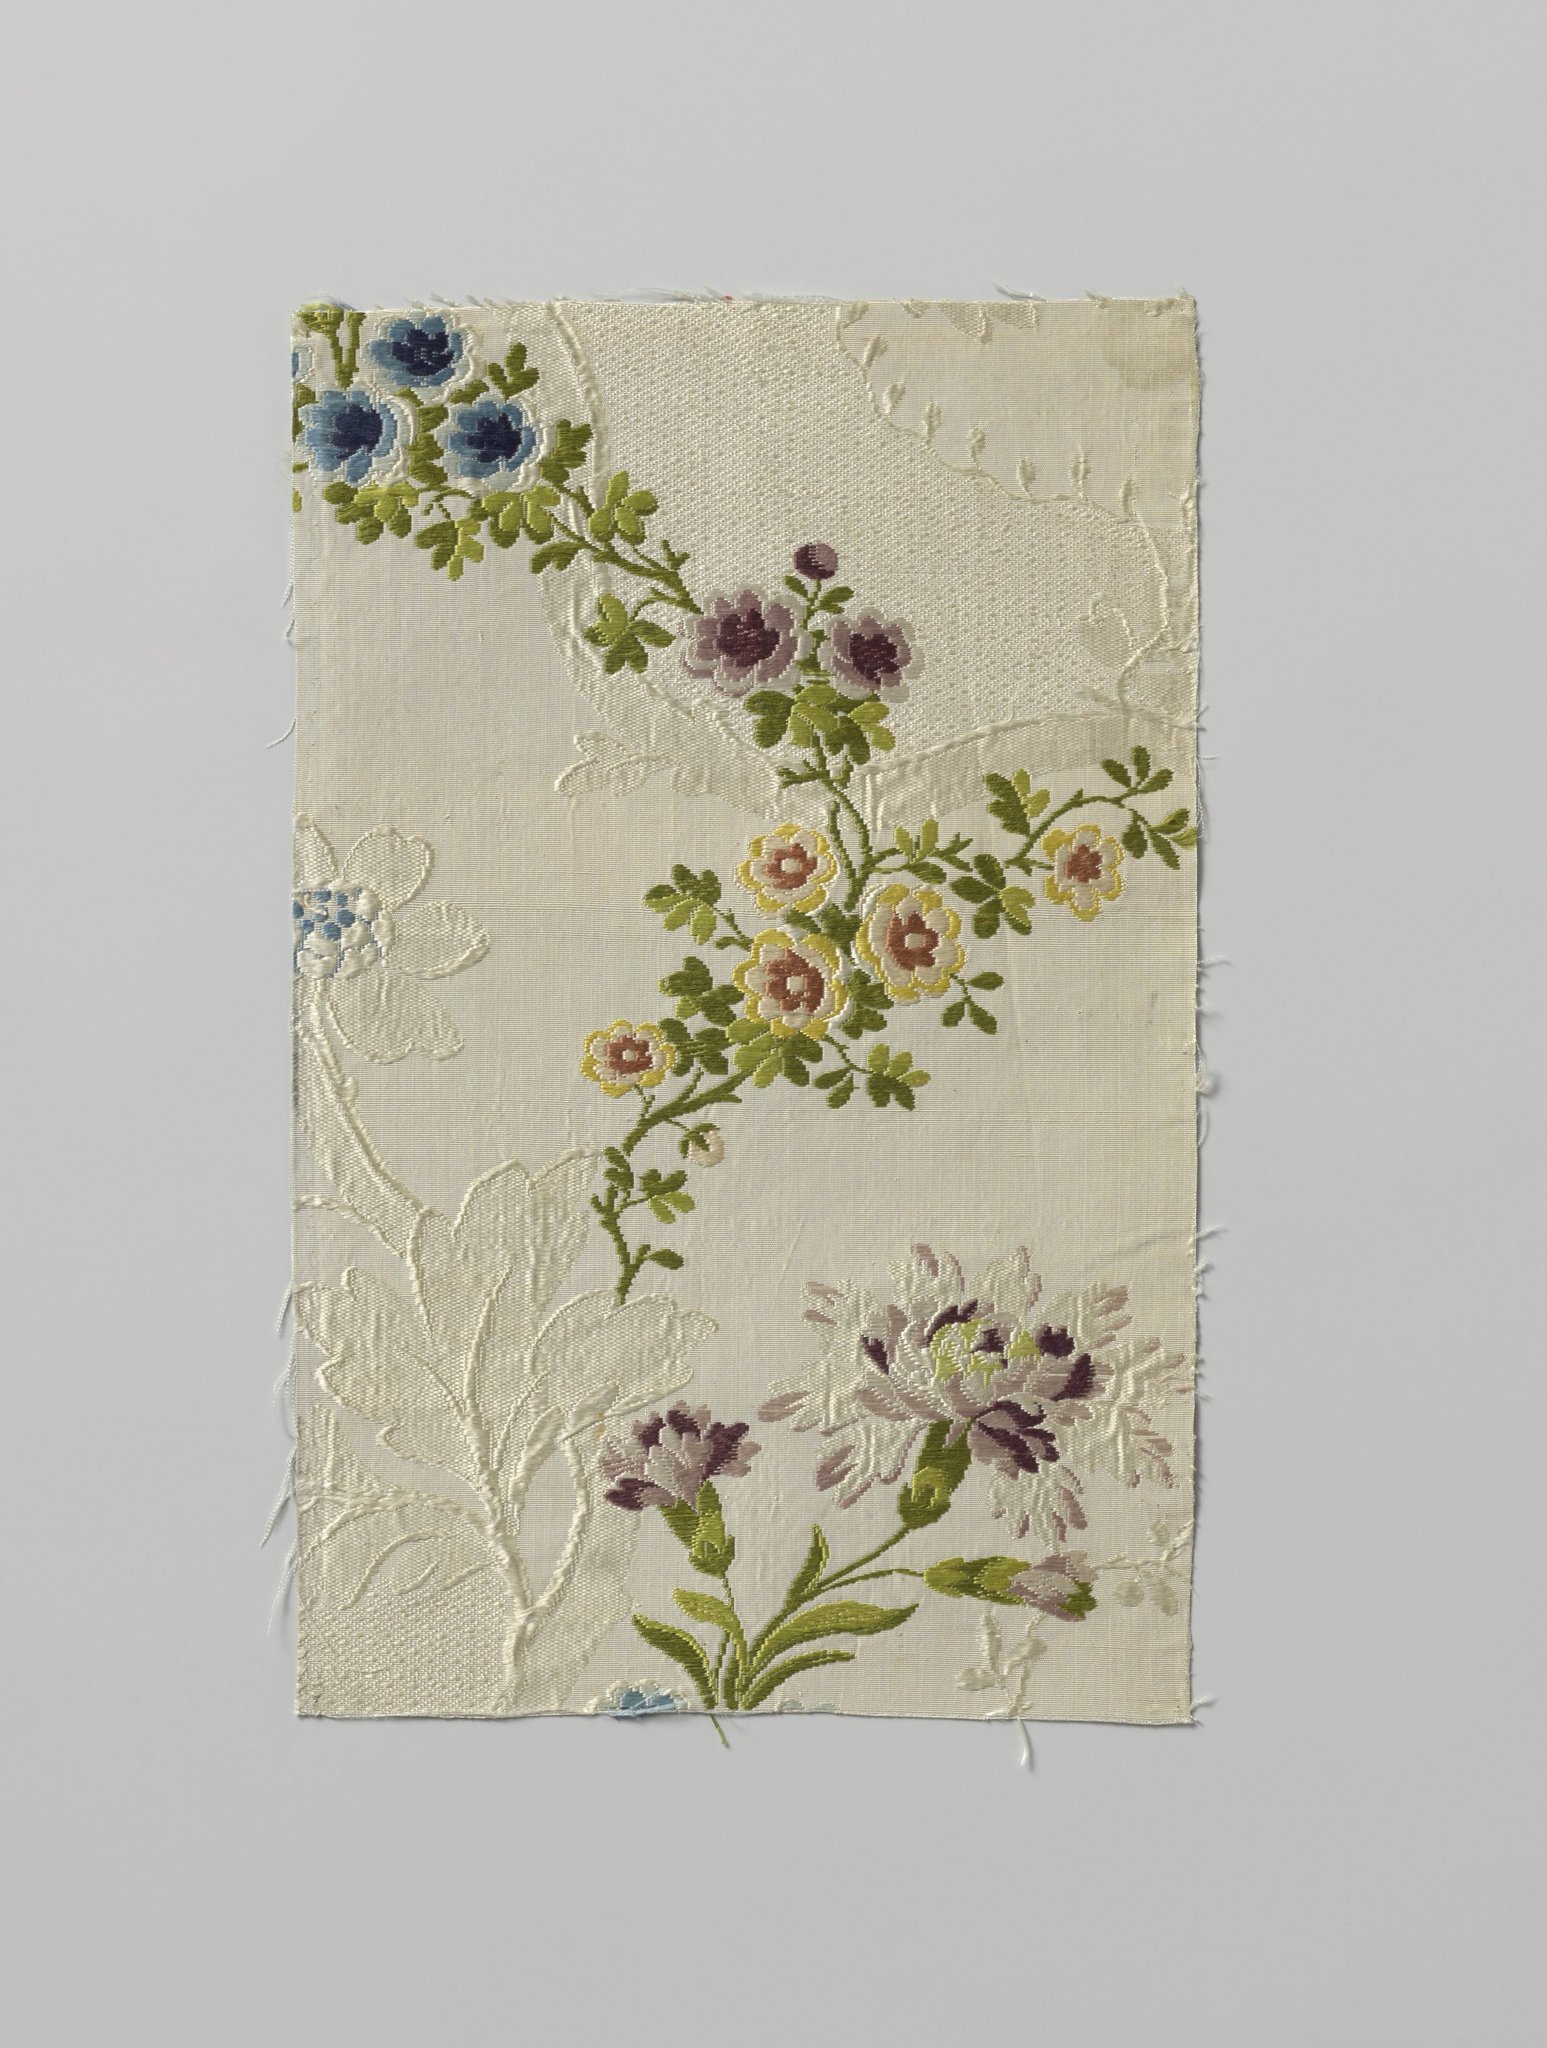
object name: fragment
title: Fragment veelkleurige gebrocheerde zijde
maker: Anonymous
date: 1740-1760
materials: silk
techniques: brocade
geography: netherlands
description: Drie fragmenten wit zijdeweefsel met een patroon van veelkleurige bloemen.